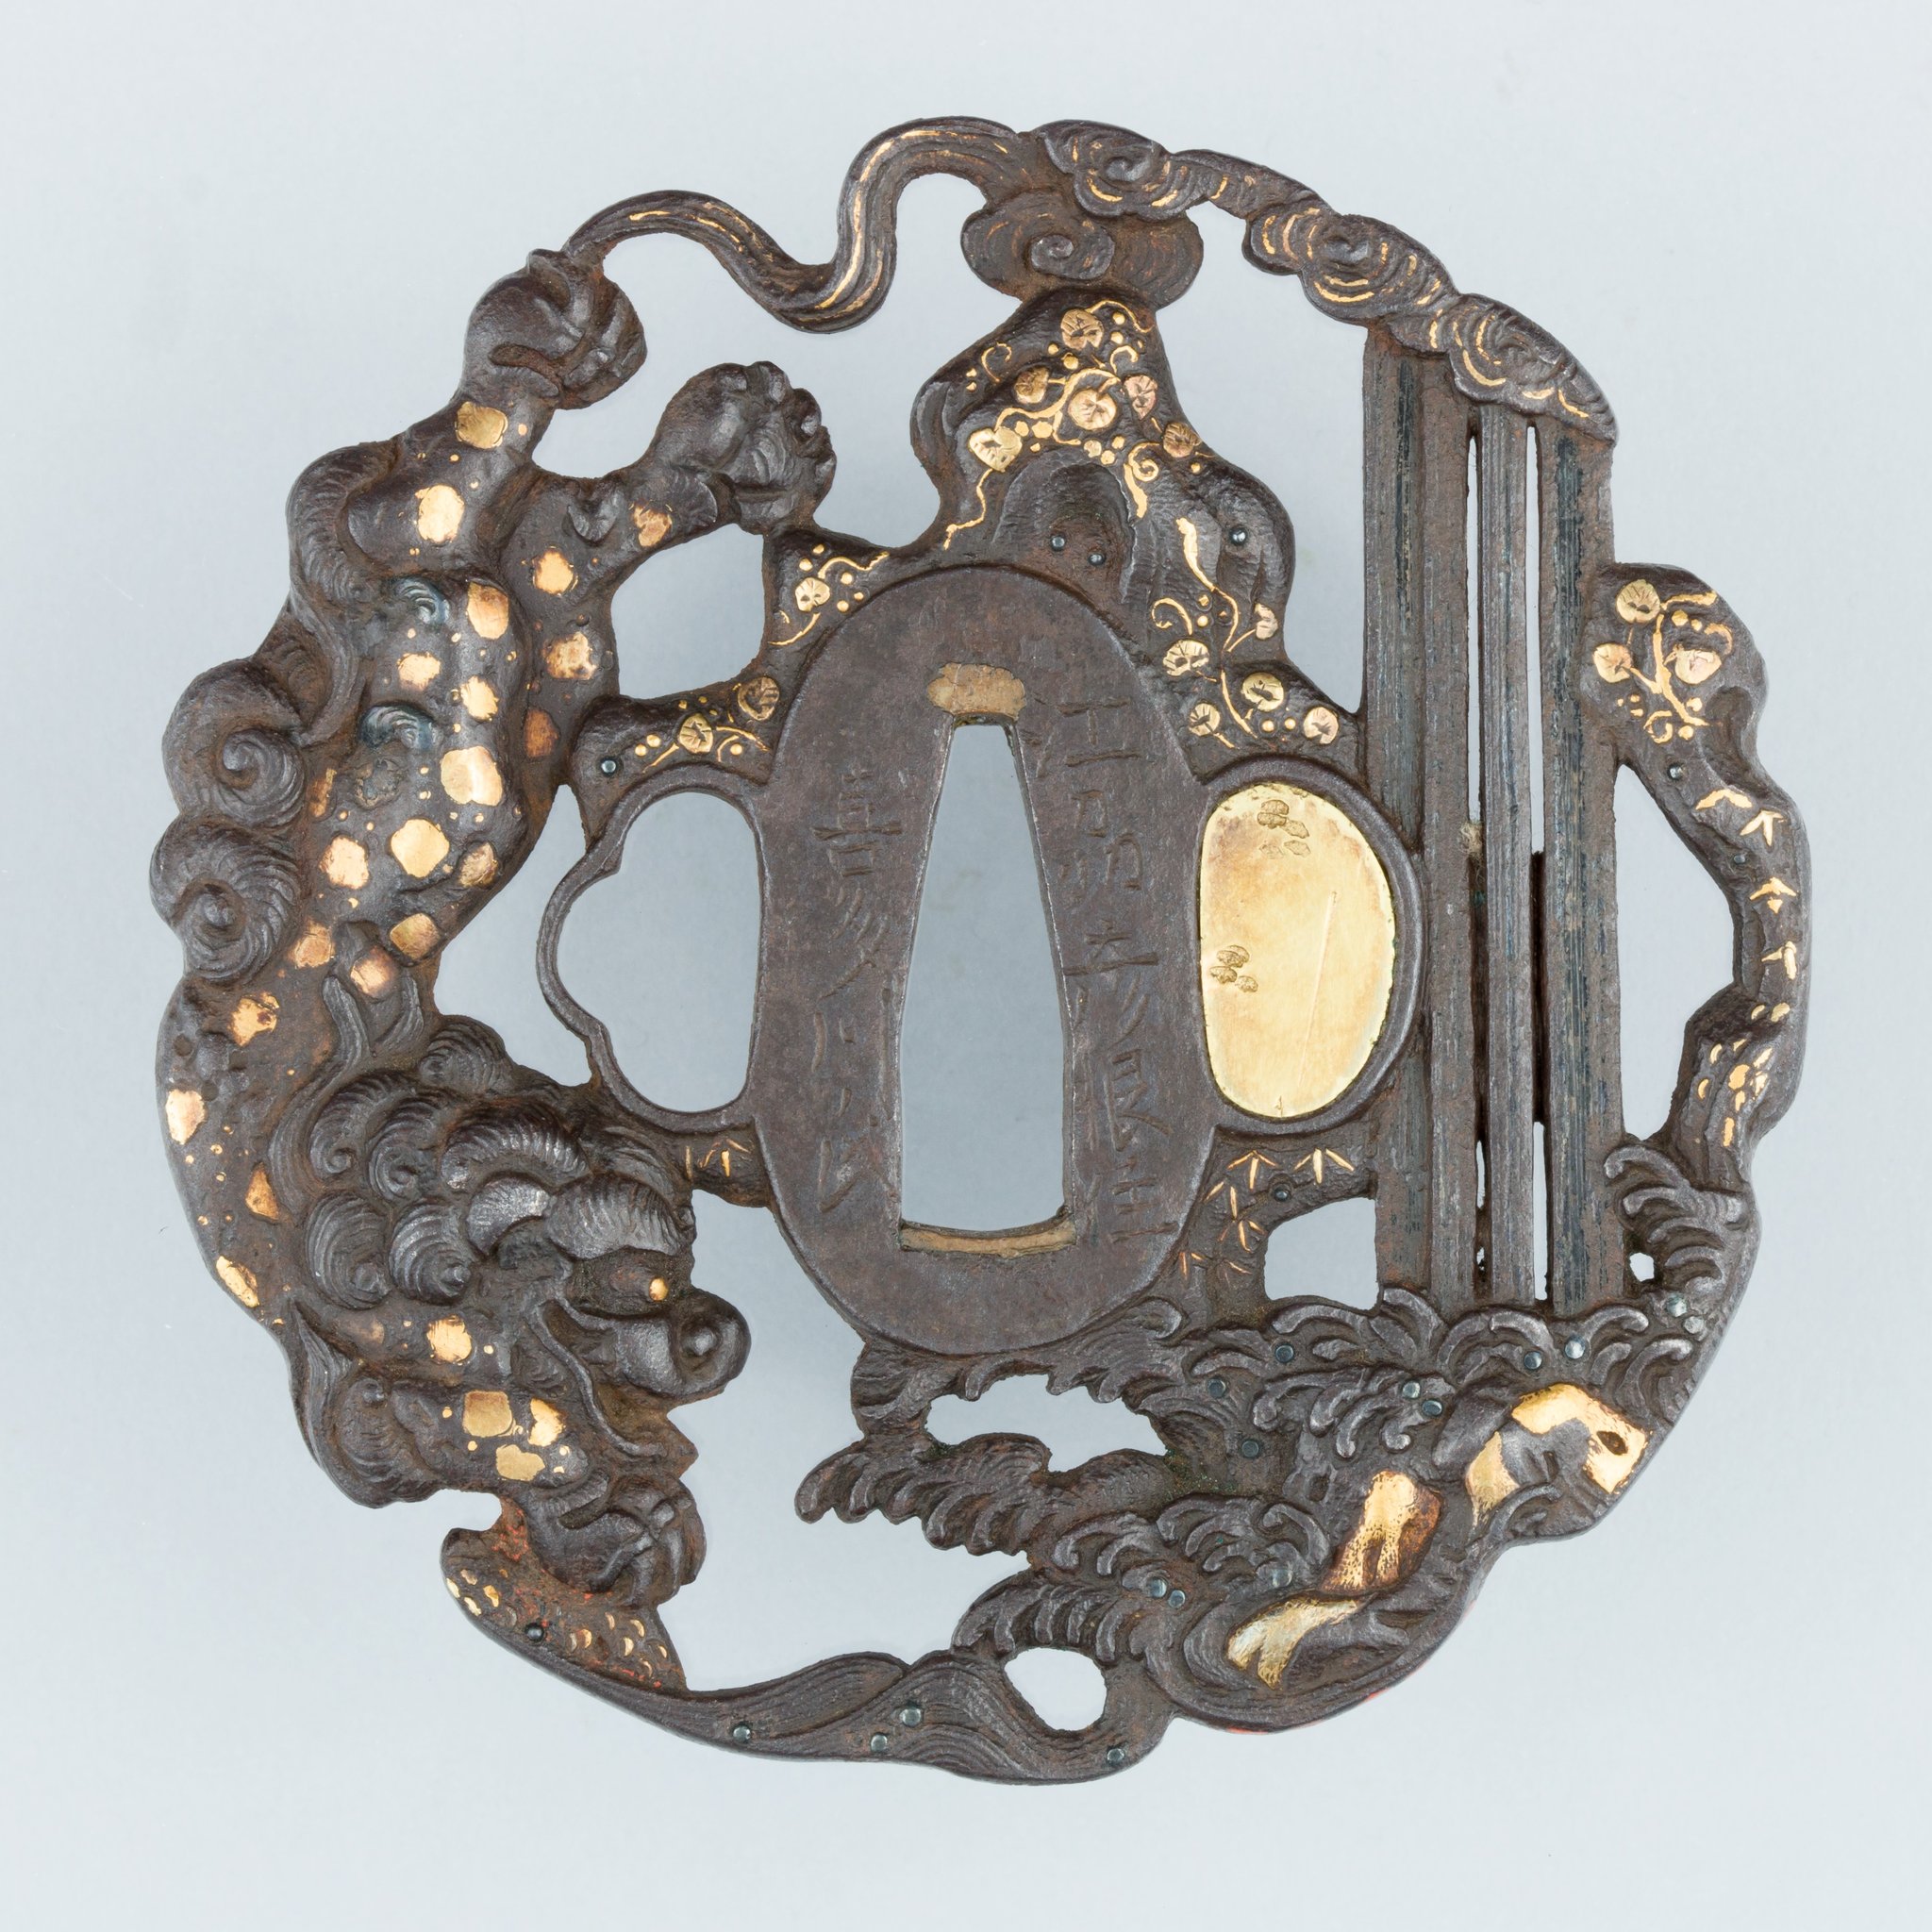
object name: sword guard tsuba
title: Sword Guard (Tsuba)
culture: japanese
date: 1667-1700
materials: copper, gold, iron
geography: japan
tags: lions